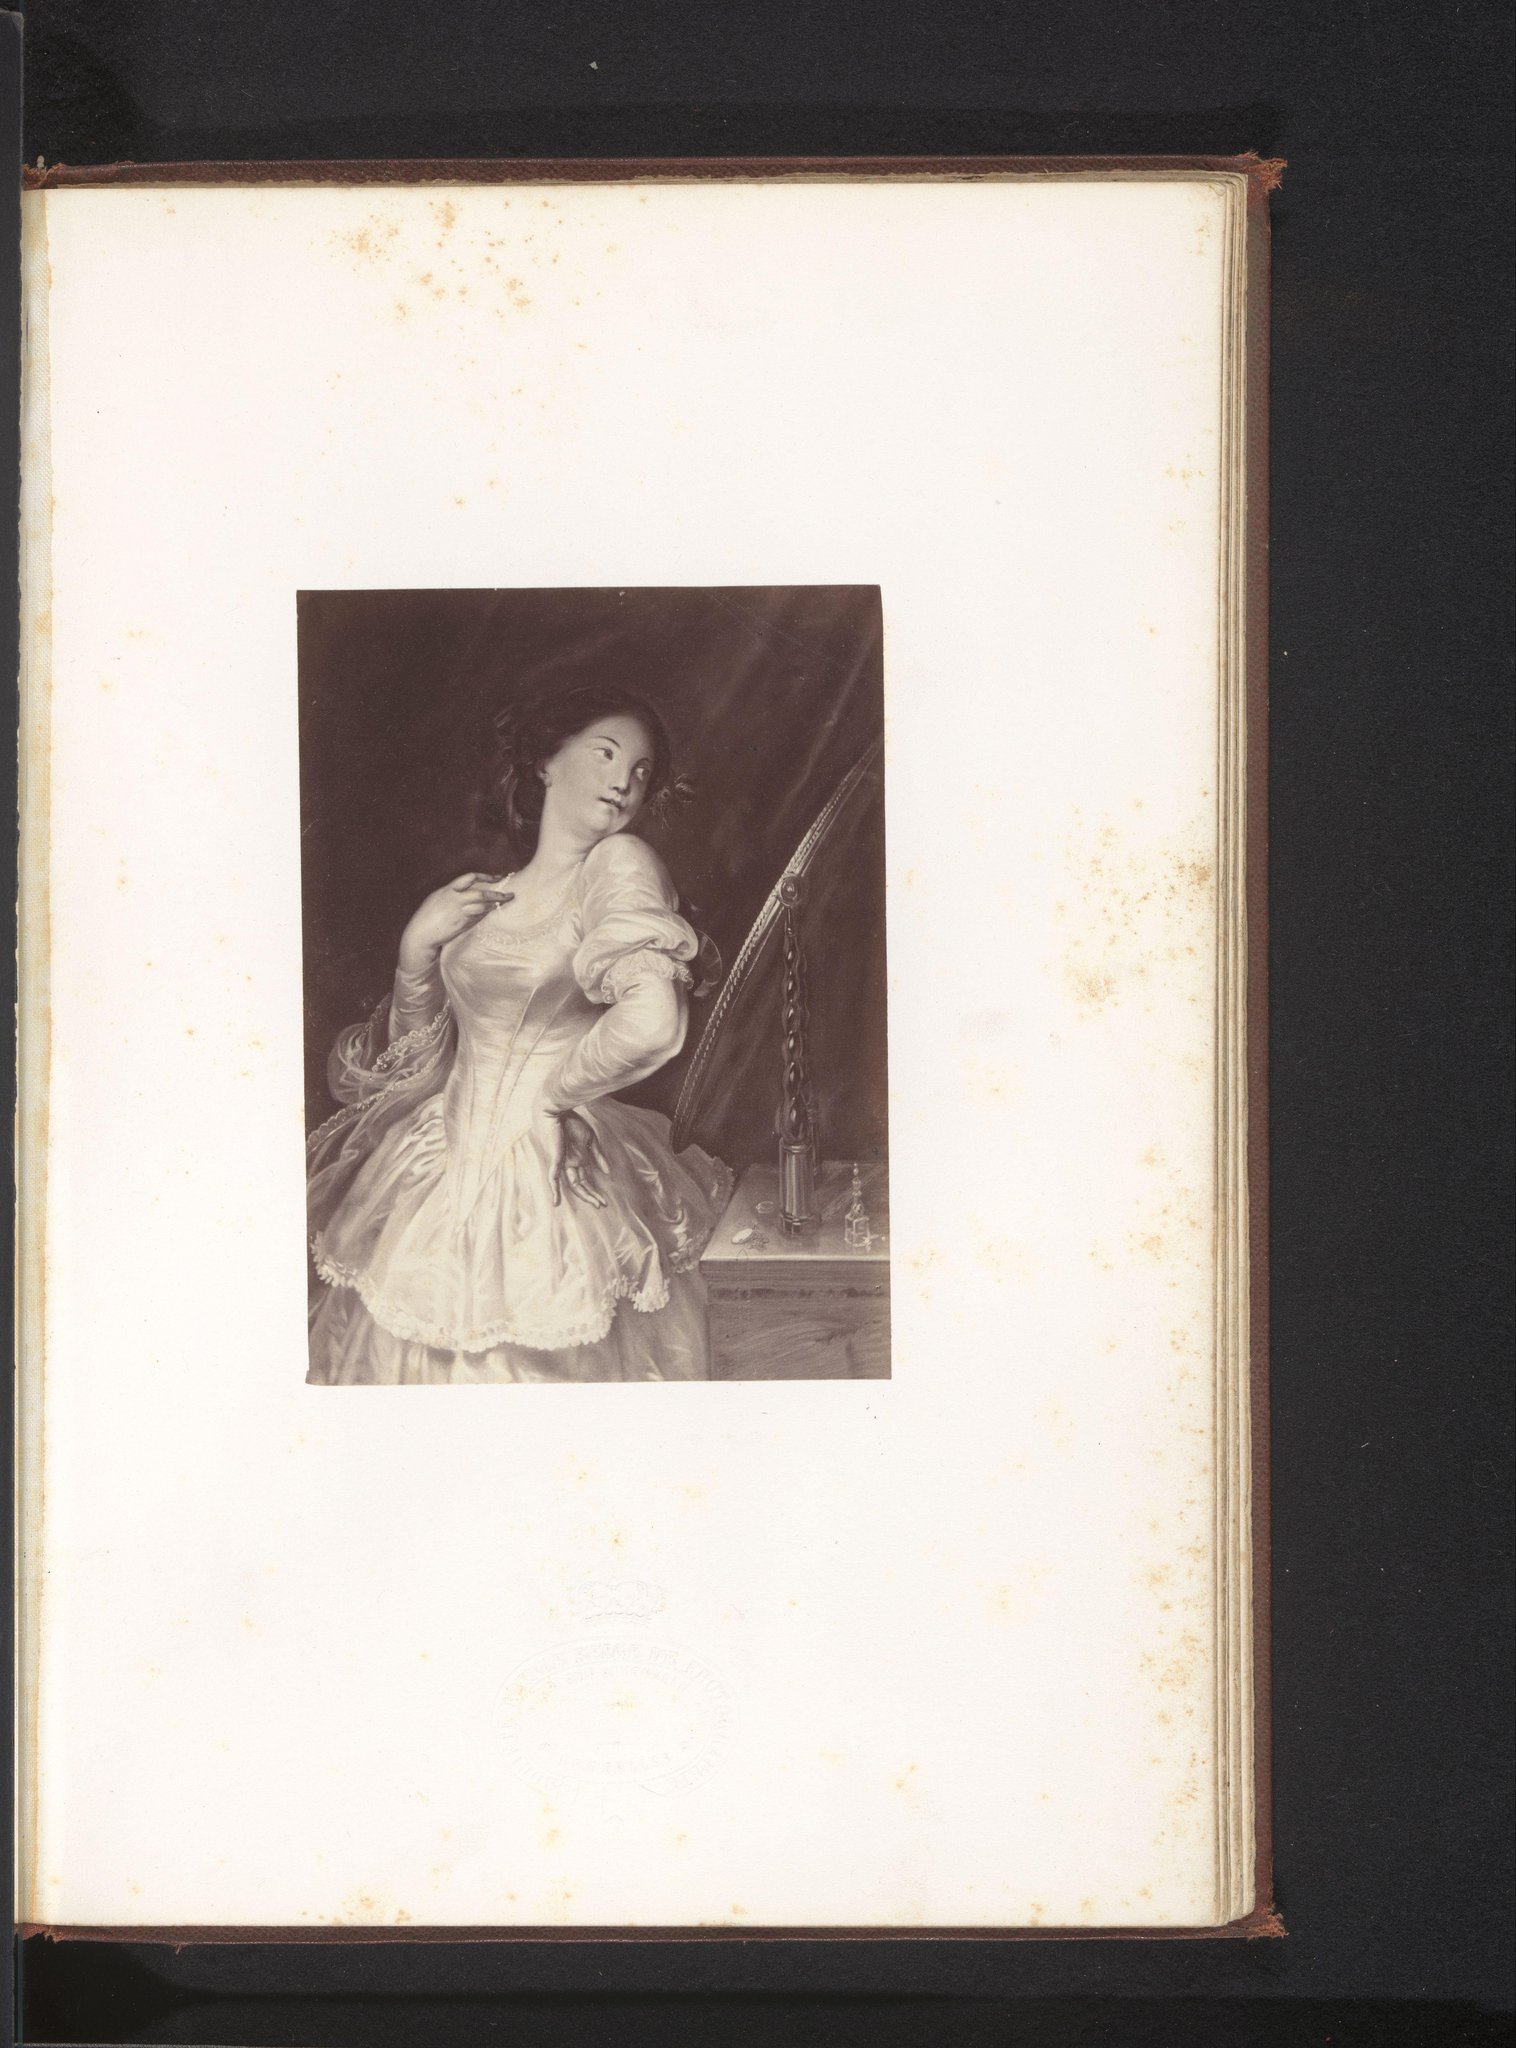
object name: page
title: Fotoreproductie van De behaagzieke, gekleed door Antoine Wiertz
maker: edmond fierlants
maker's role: fotograaf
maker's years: 1819-1869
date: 1863-1868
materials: photographic support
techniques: albumen print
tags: looking in the mirror; (possibly: contemplation of own beauty - aa - (for) women)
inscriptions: check stamp: ‘SOCIÉTÉ ROYALE BELGE DE PHOTOGRAPHIE/ 69, RUE KEYENVELD/ BRUXELLES’